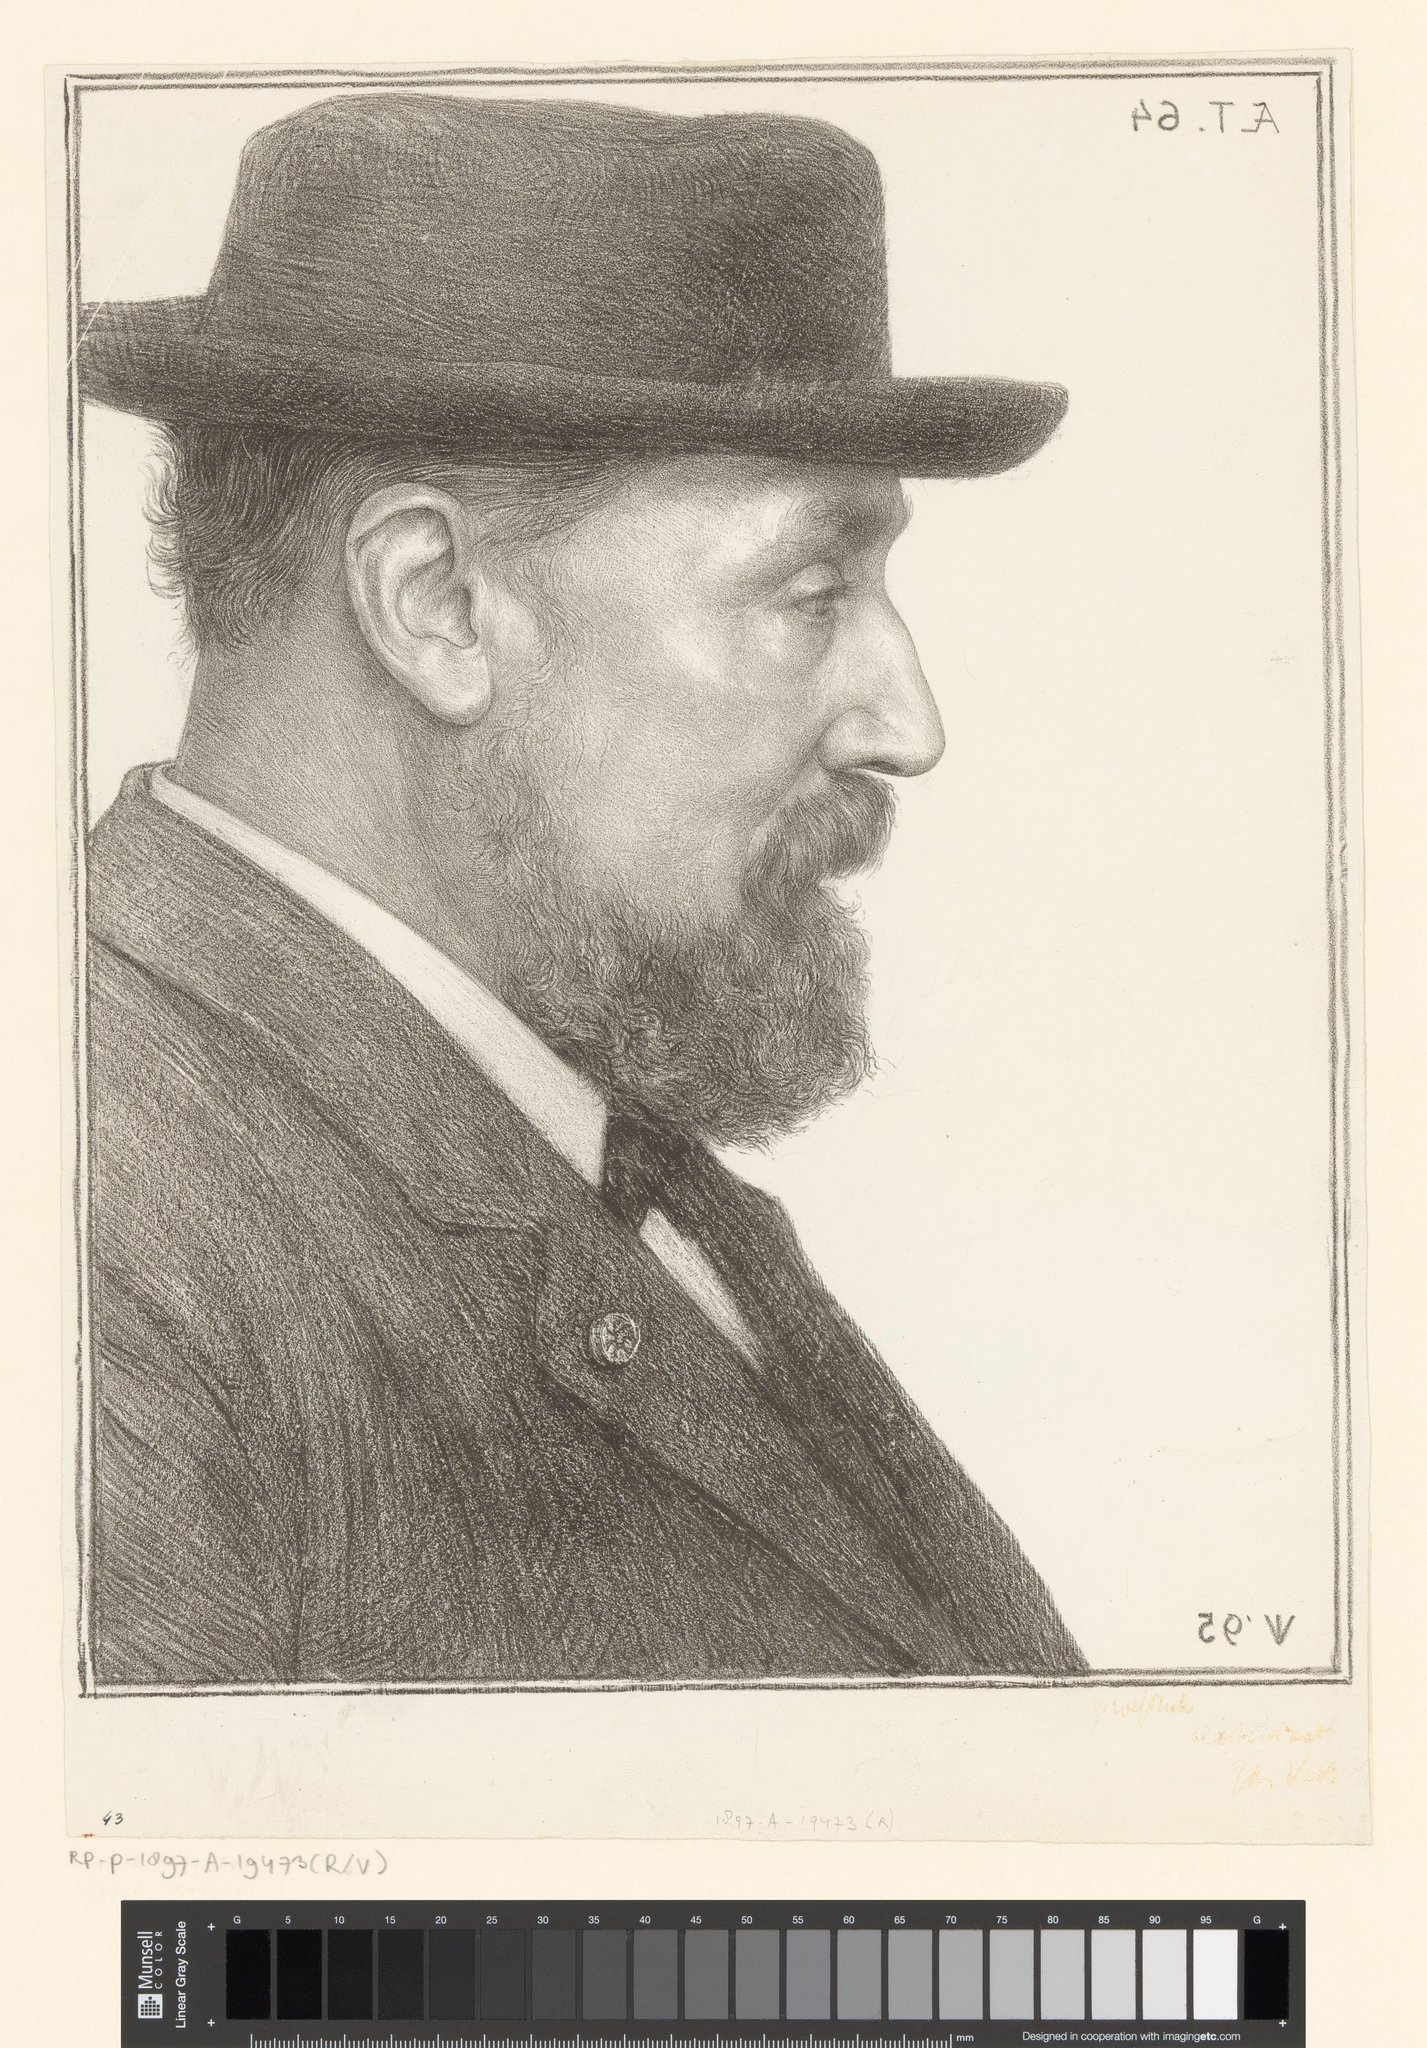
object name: print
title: Portretten van De Kroniek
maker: jan veth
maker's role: designer, draughtsman, painter, print maker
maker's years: 1864-1925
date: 1895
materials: paper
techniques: lithograph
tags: the hague, draughtsman, hendrik willem mesdag, historical persons (+ (full) bust portrait)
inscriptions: inscription: ‘proefdruk / eerste staat / Jan Veth’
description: Deze prent werd uitgegeven als bijvoegsel van De Kroniek op 24 februari 1895.